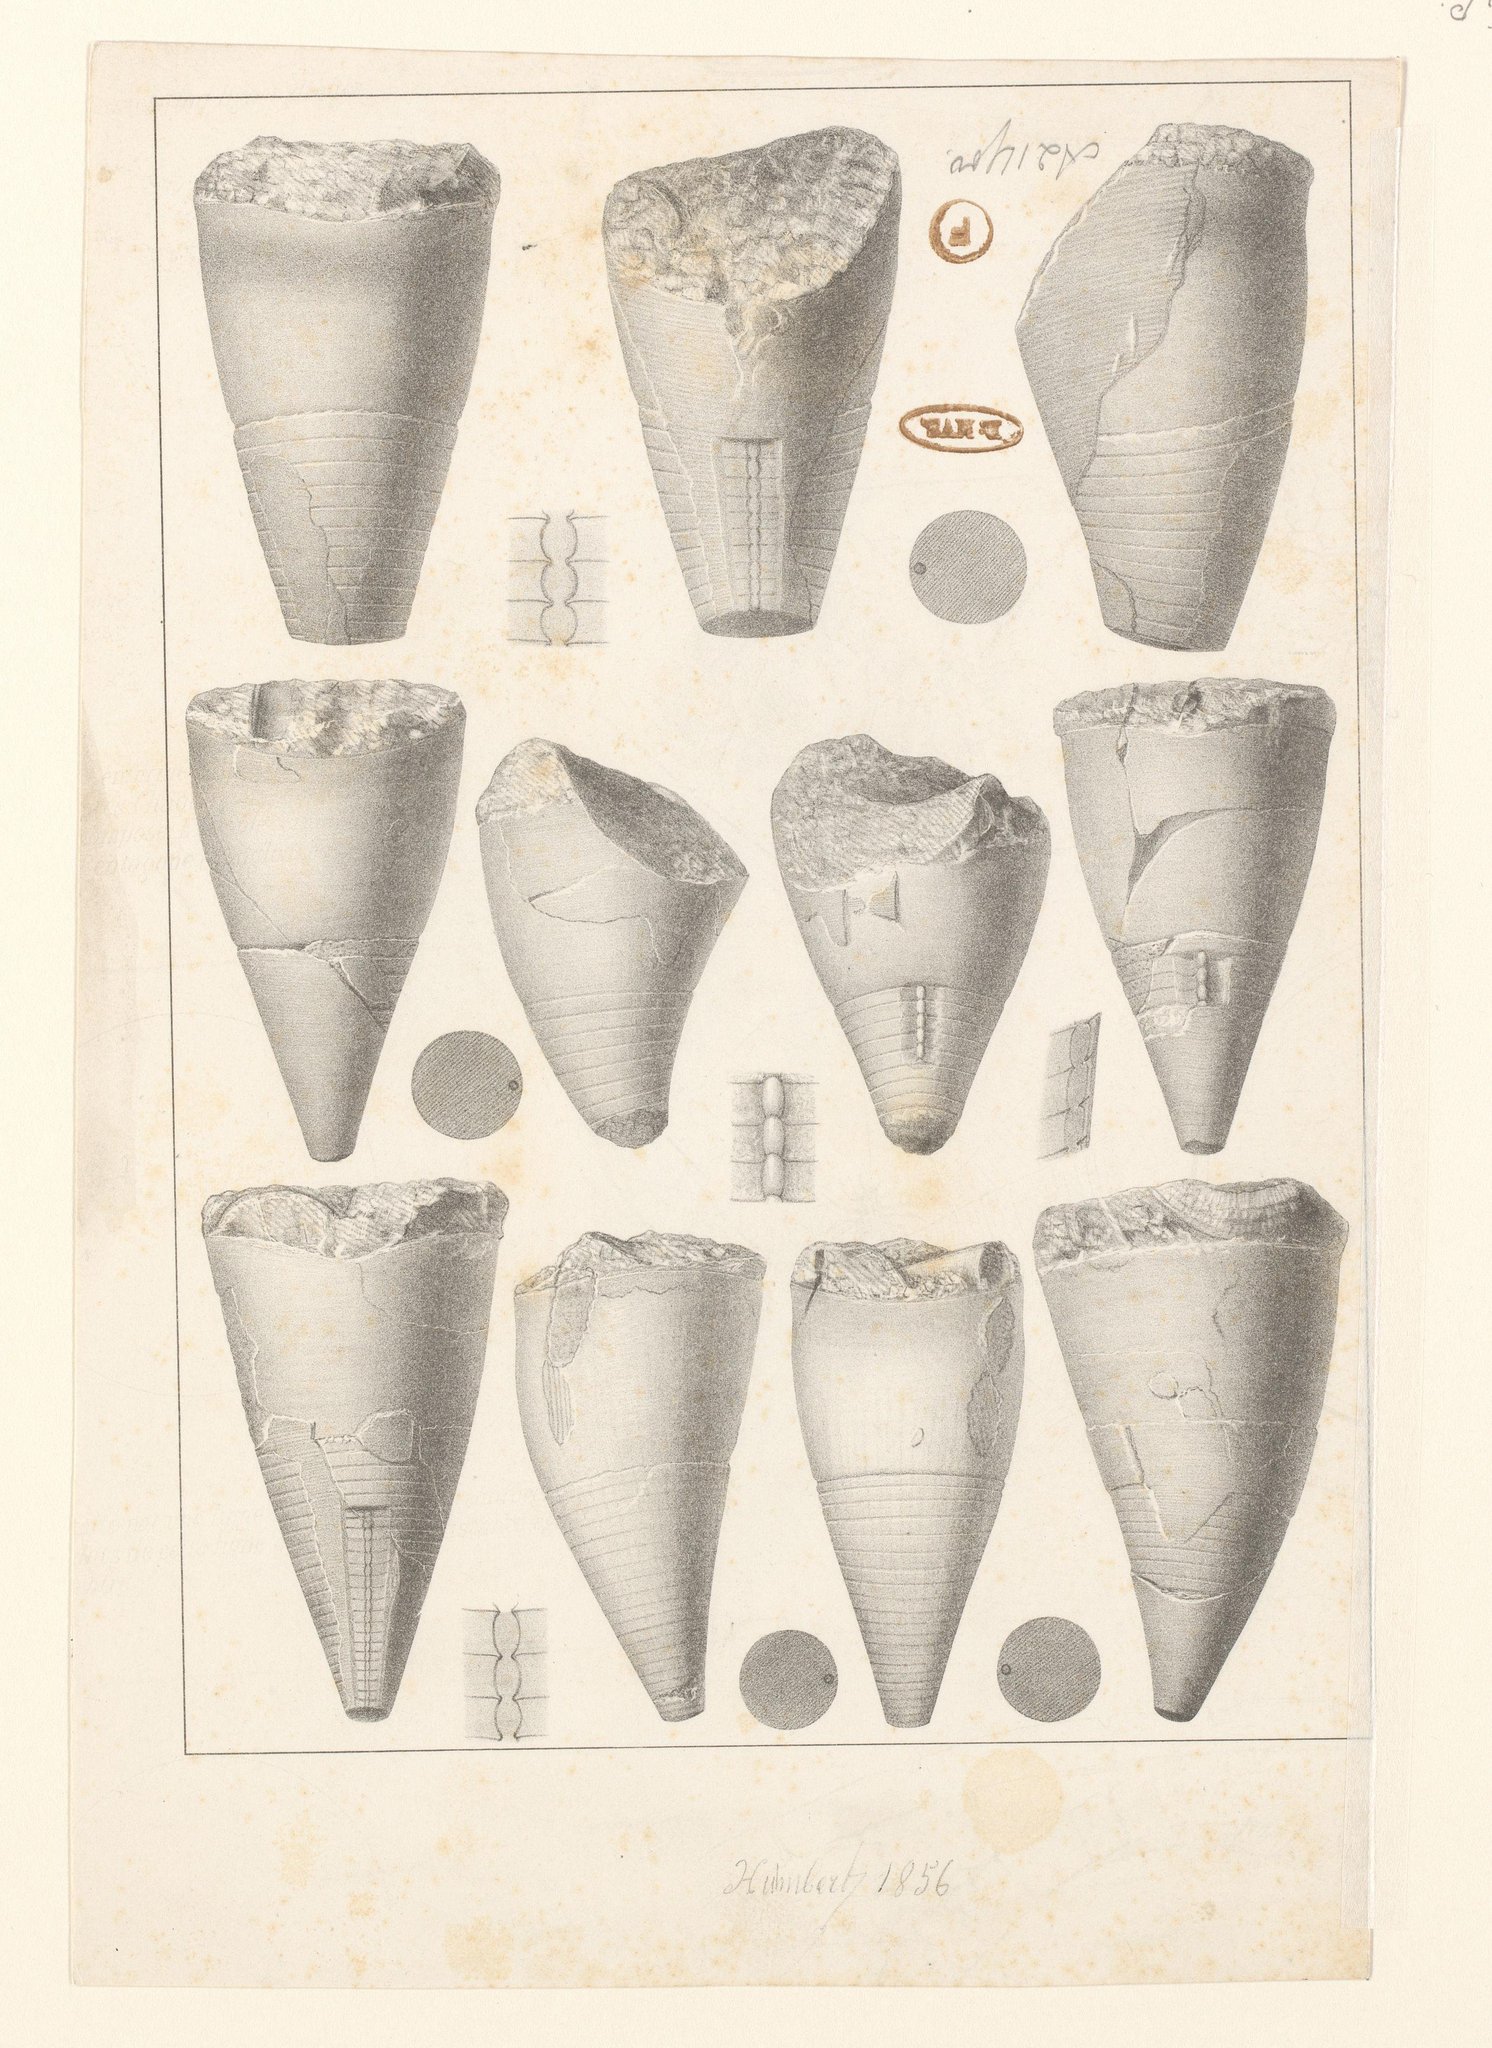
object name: print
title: Elf kegelvormige sculpturale elementen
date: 1857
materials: paper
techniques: lithograph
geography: paris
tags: sculpture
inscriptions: collector's mark: Lugt 964